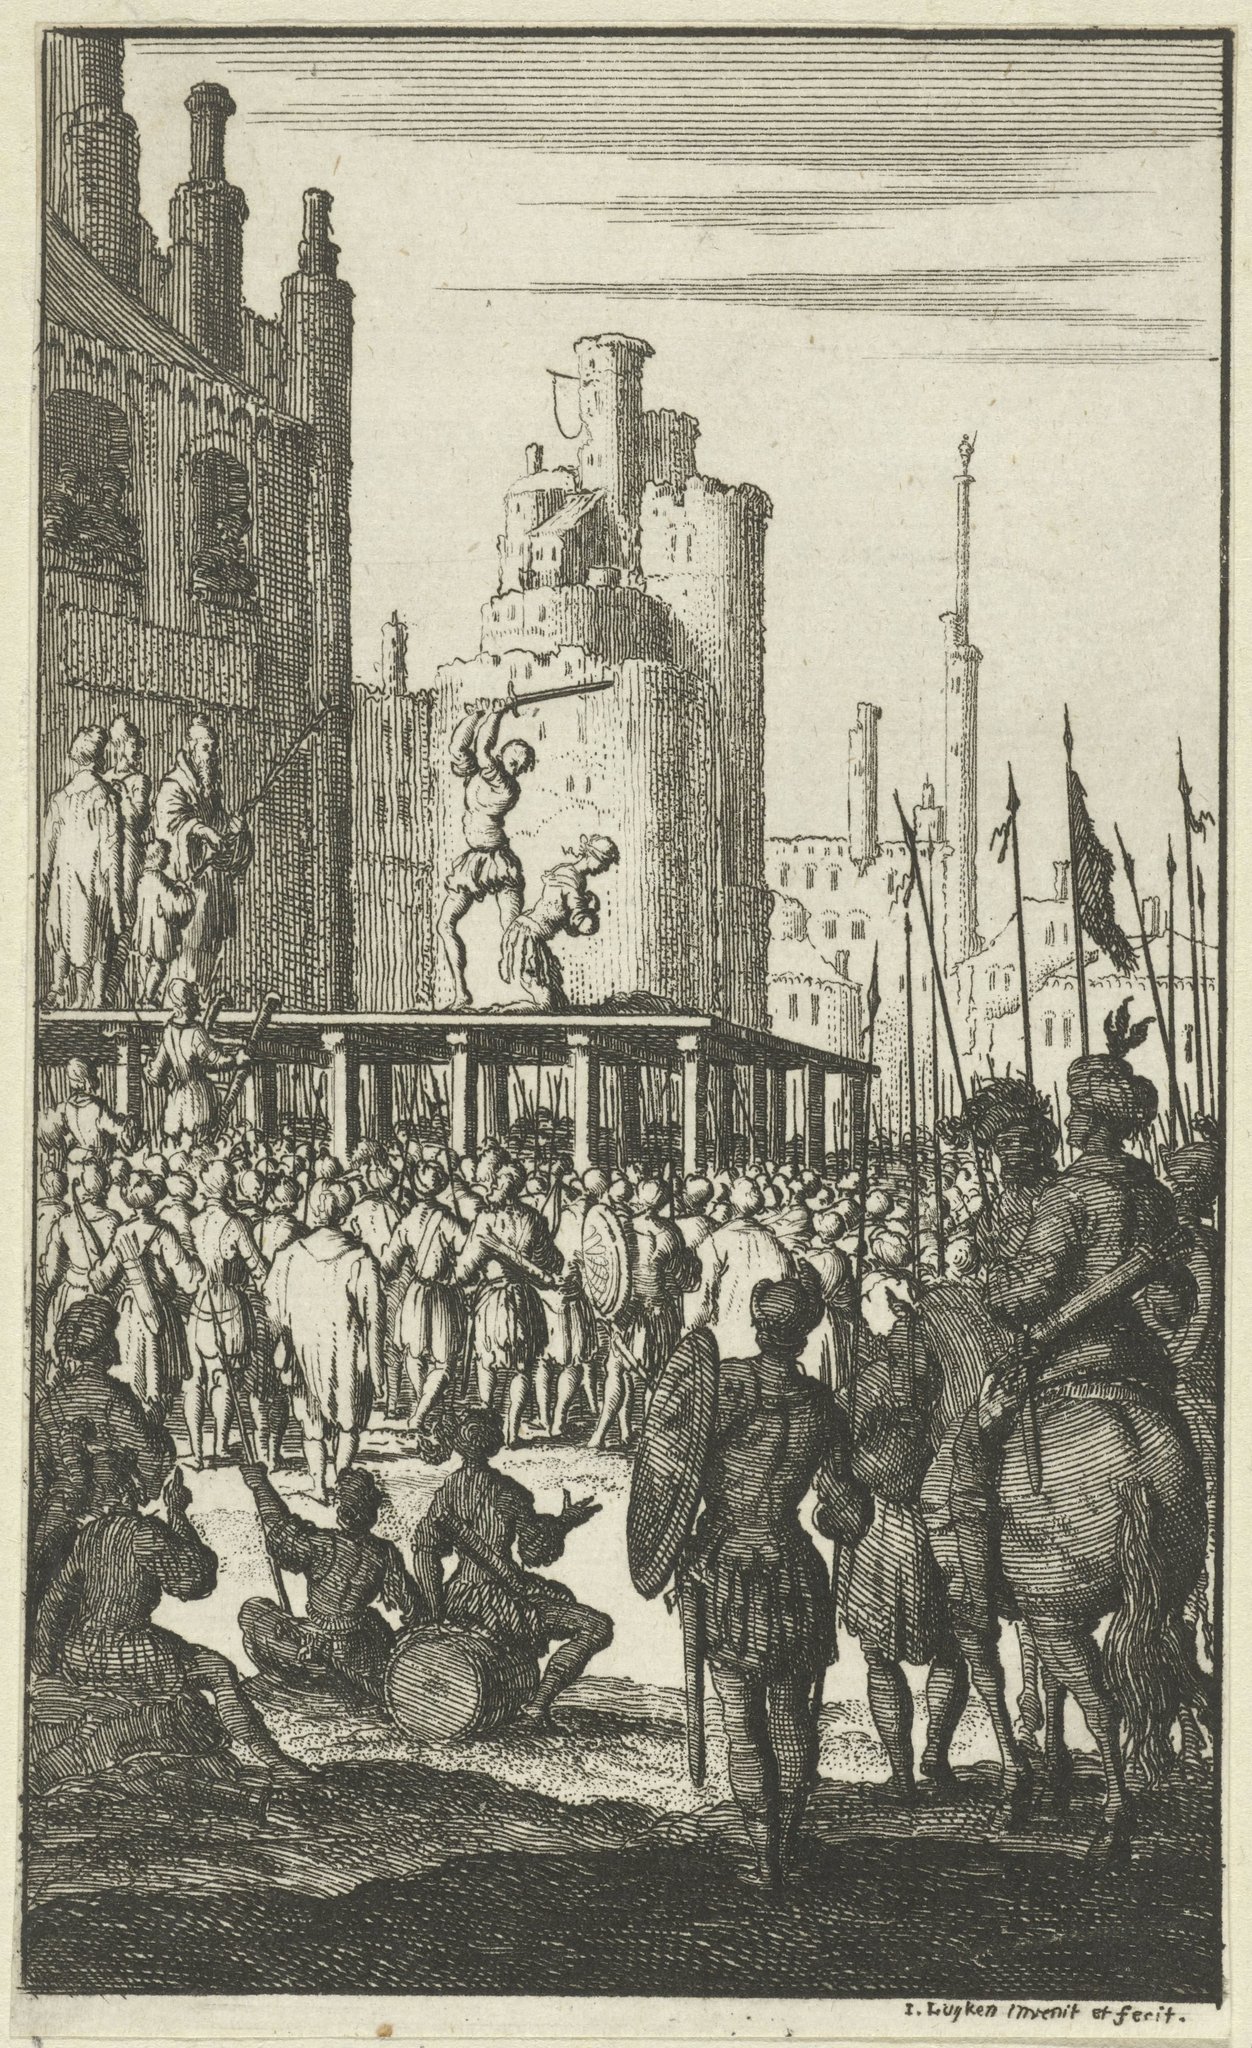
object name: book illustration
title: Onthoofding van Ambiodorix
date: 1681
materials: paper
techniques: etching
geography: amsterdam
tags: violent death by beheading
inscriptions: collector's mark: Lugt 240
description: Illustratie opgenomen in het tweede deel van: Barclay, John. D'Argenis, 2 delen. Amsterdam: Jan Claesz ten Hoorn, 1680-1681.